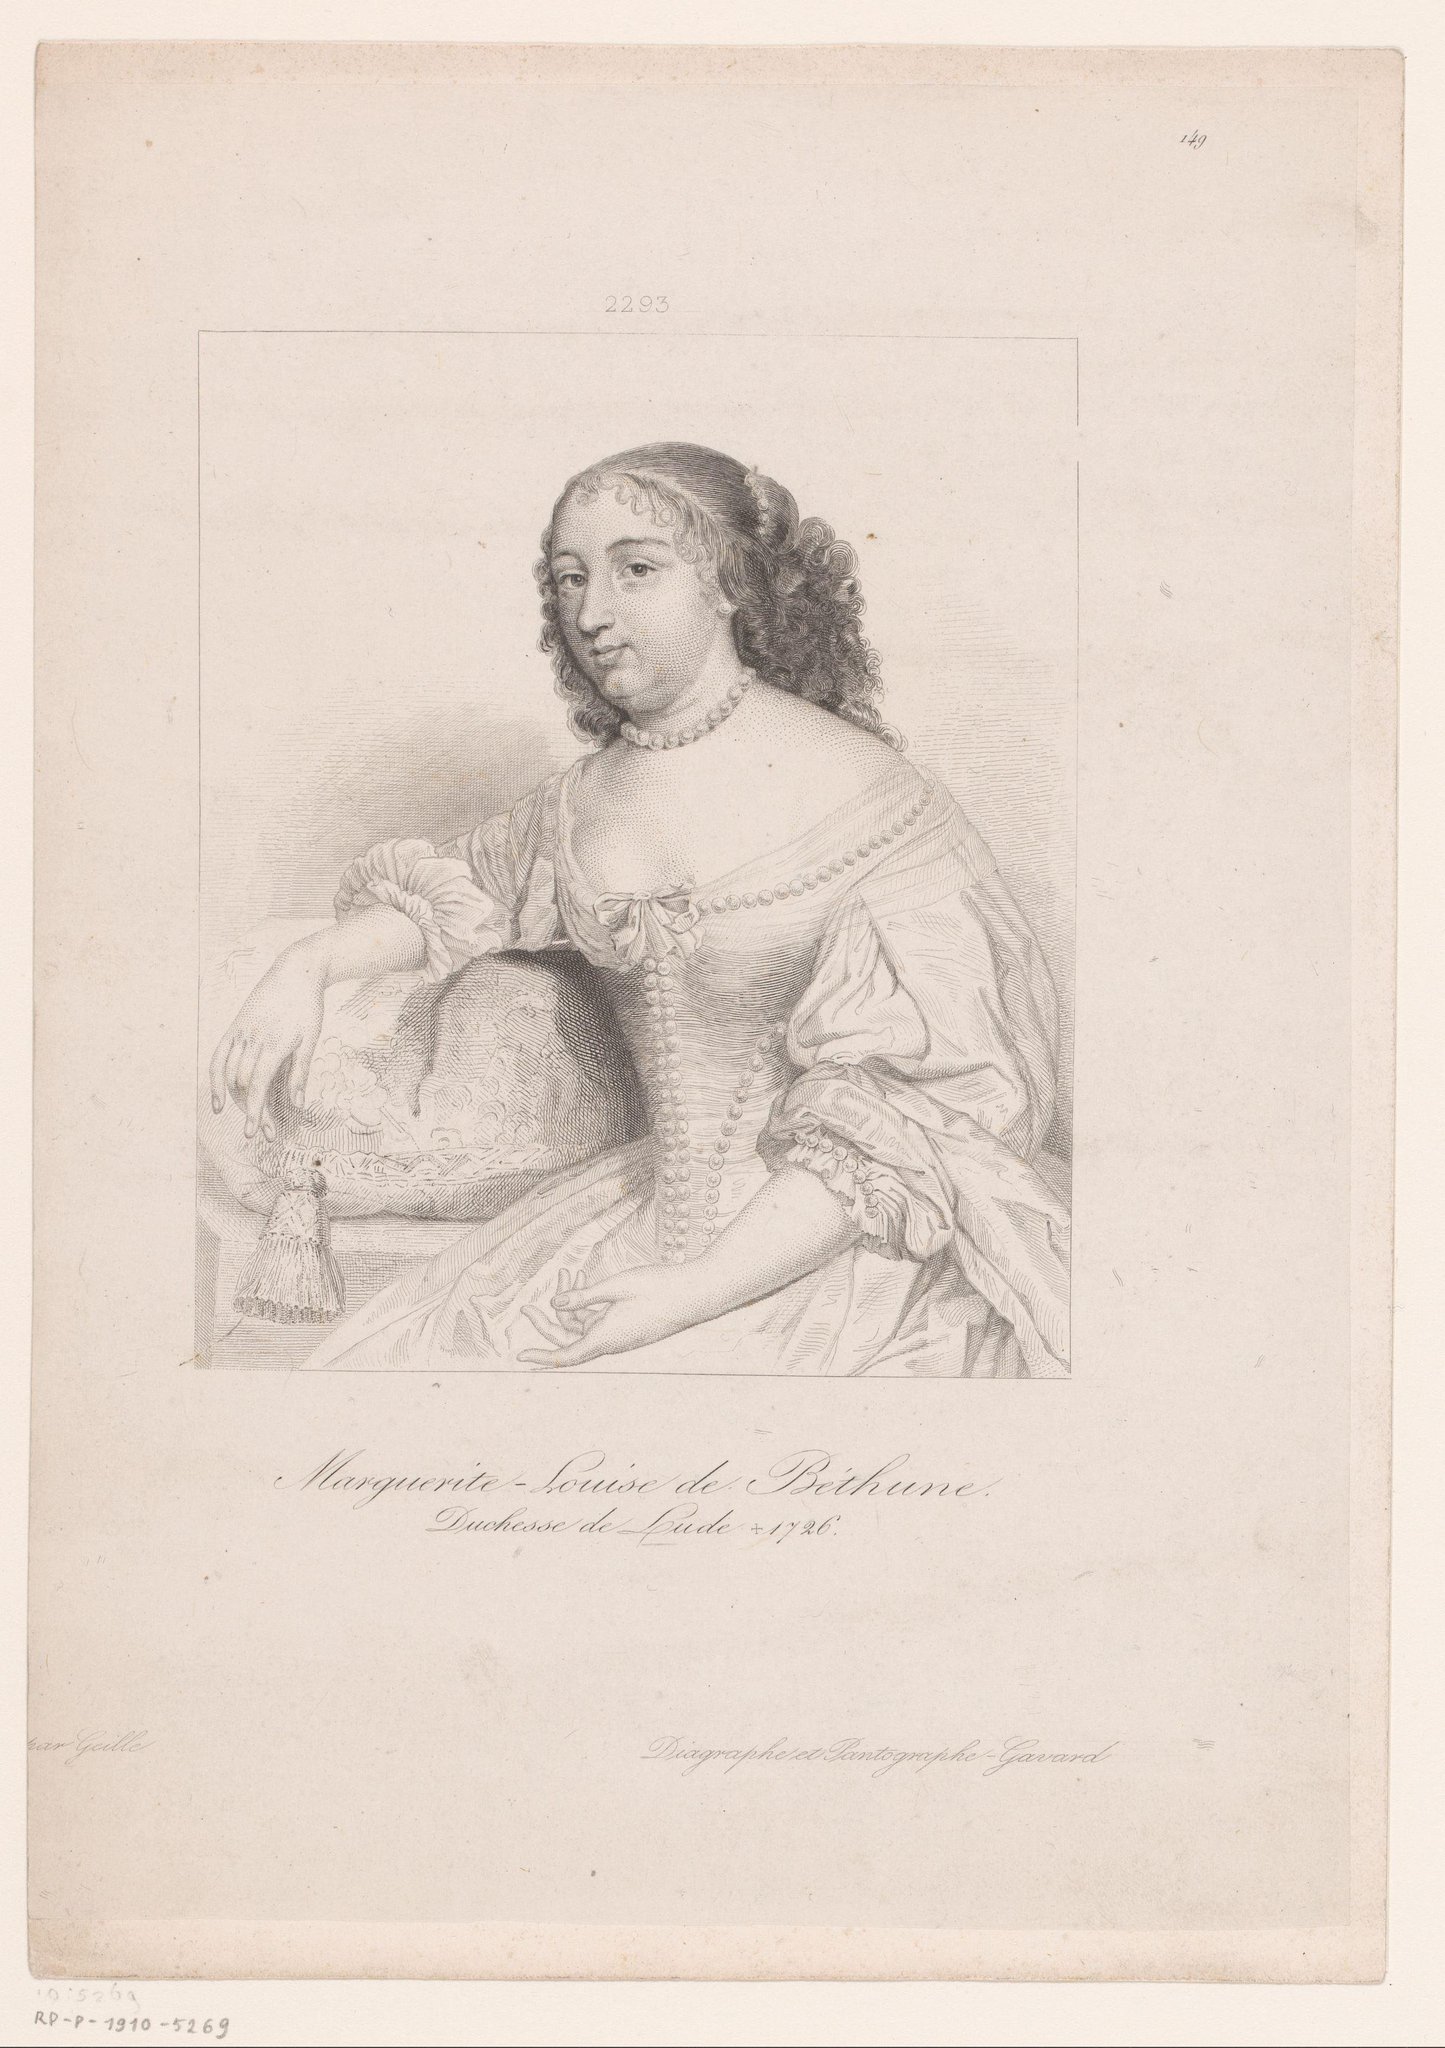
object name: book illustration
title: Portret van Marguerite Louise de Béthune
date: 1838-1841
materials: paper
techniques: engraving, etching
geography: france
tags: sitting figure - aa - female human figure, historical persons - bb - woman, pillow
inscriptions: collector's mark: Lugt 2228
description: Prent uit: Galeries historiques de Versailles. Parijs: Charles Gavard, 1838-1841, p. 149.